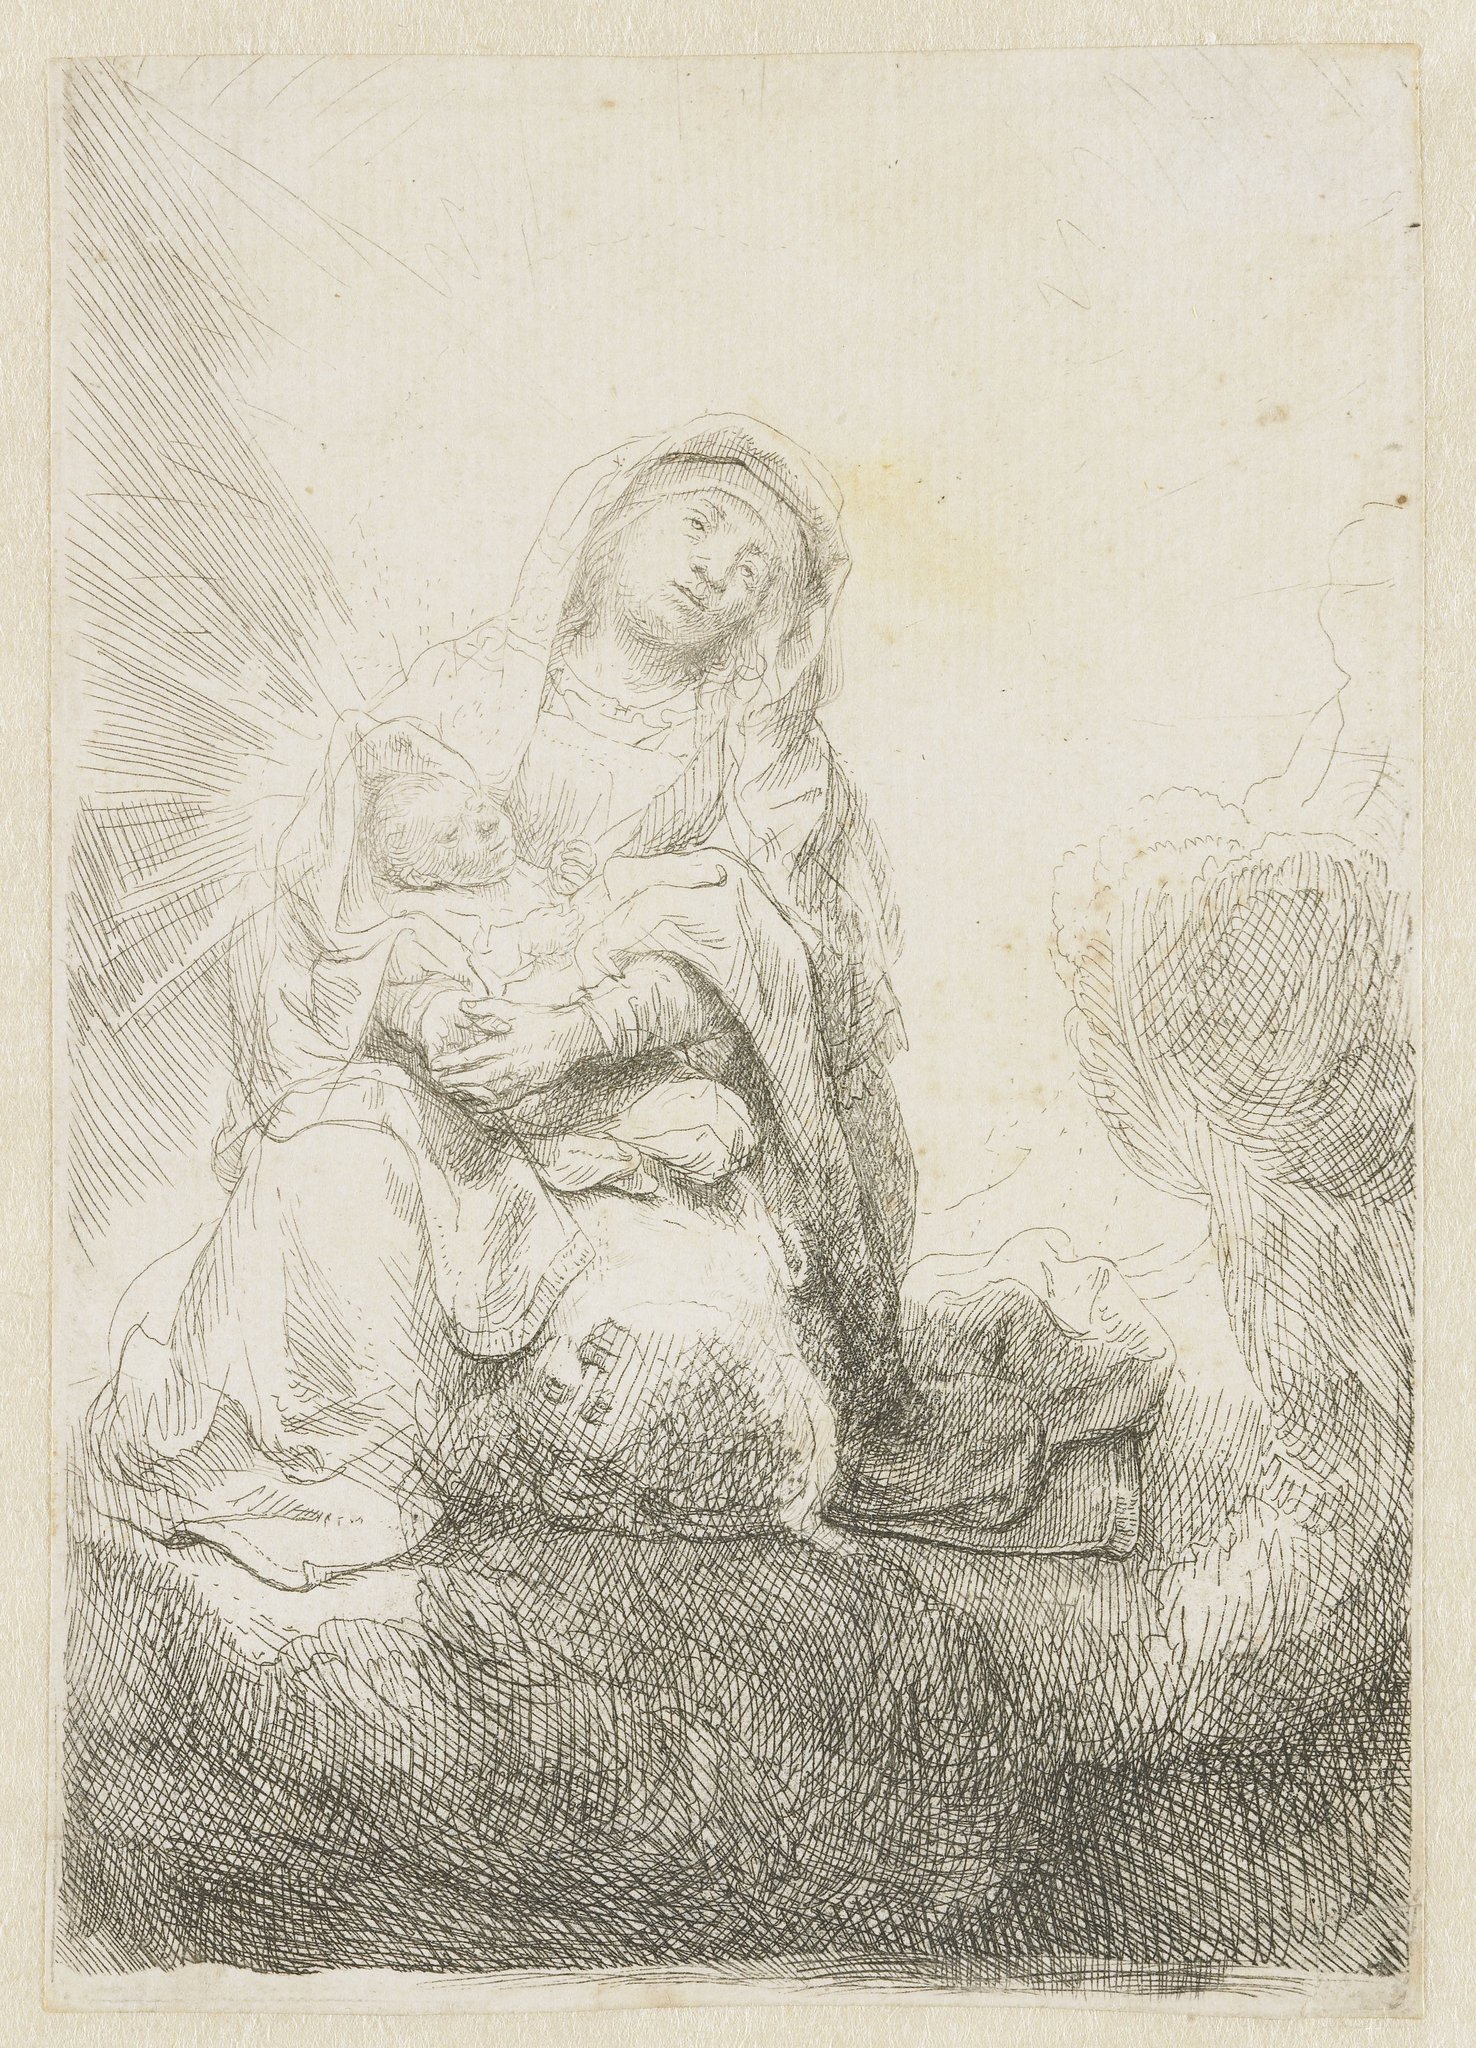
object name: print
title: The Virgin and Child in the clouds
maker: rembrandt van rijn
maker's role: draughtsman, painter, print maker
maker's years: 1606-1669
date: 1641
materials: paper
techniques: drypoint, etching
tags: madonna (i.e. mary with the christ-child) in the air, or on the clouds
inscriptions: mark: Lugt 1138 c, mark: Lugt 2228, signature and date: ‘Rembrandt f. 1641’